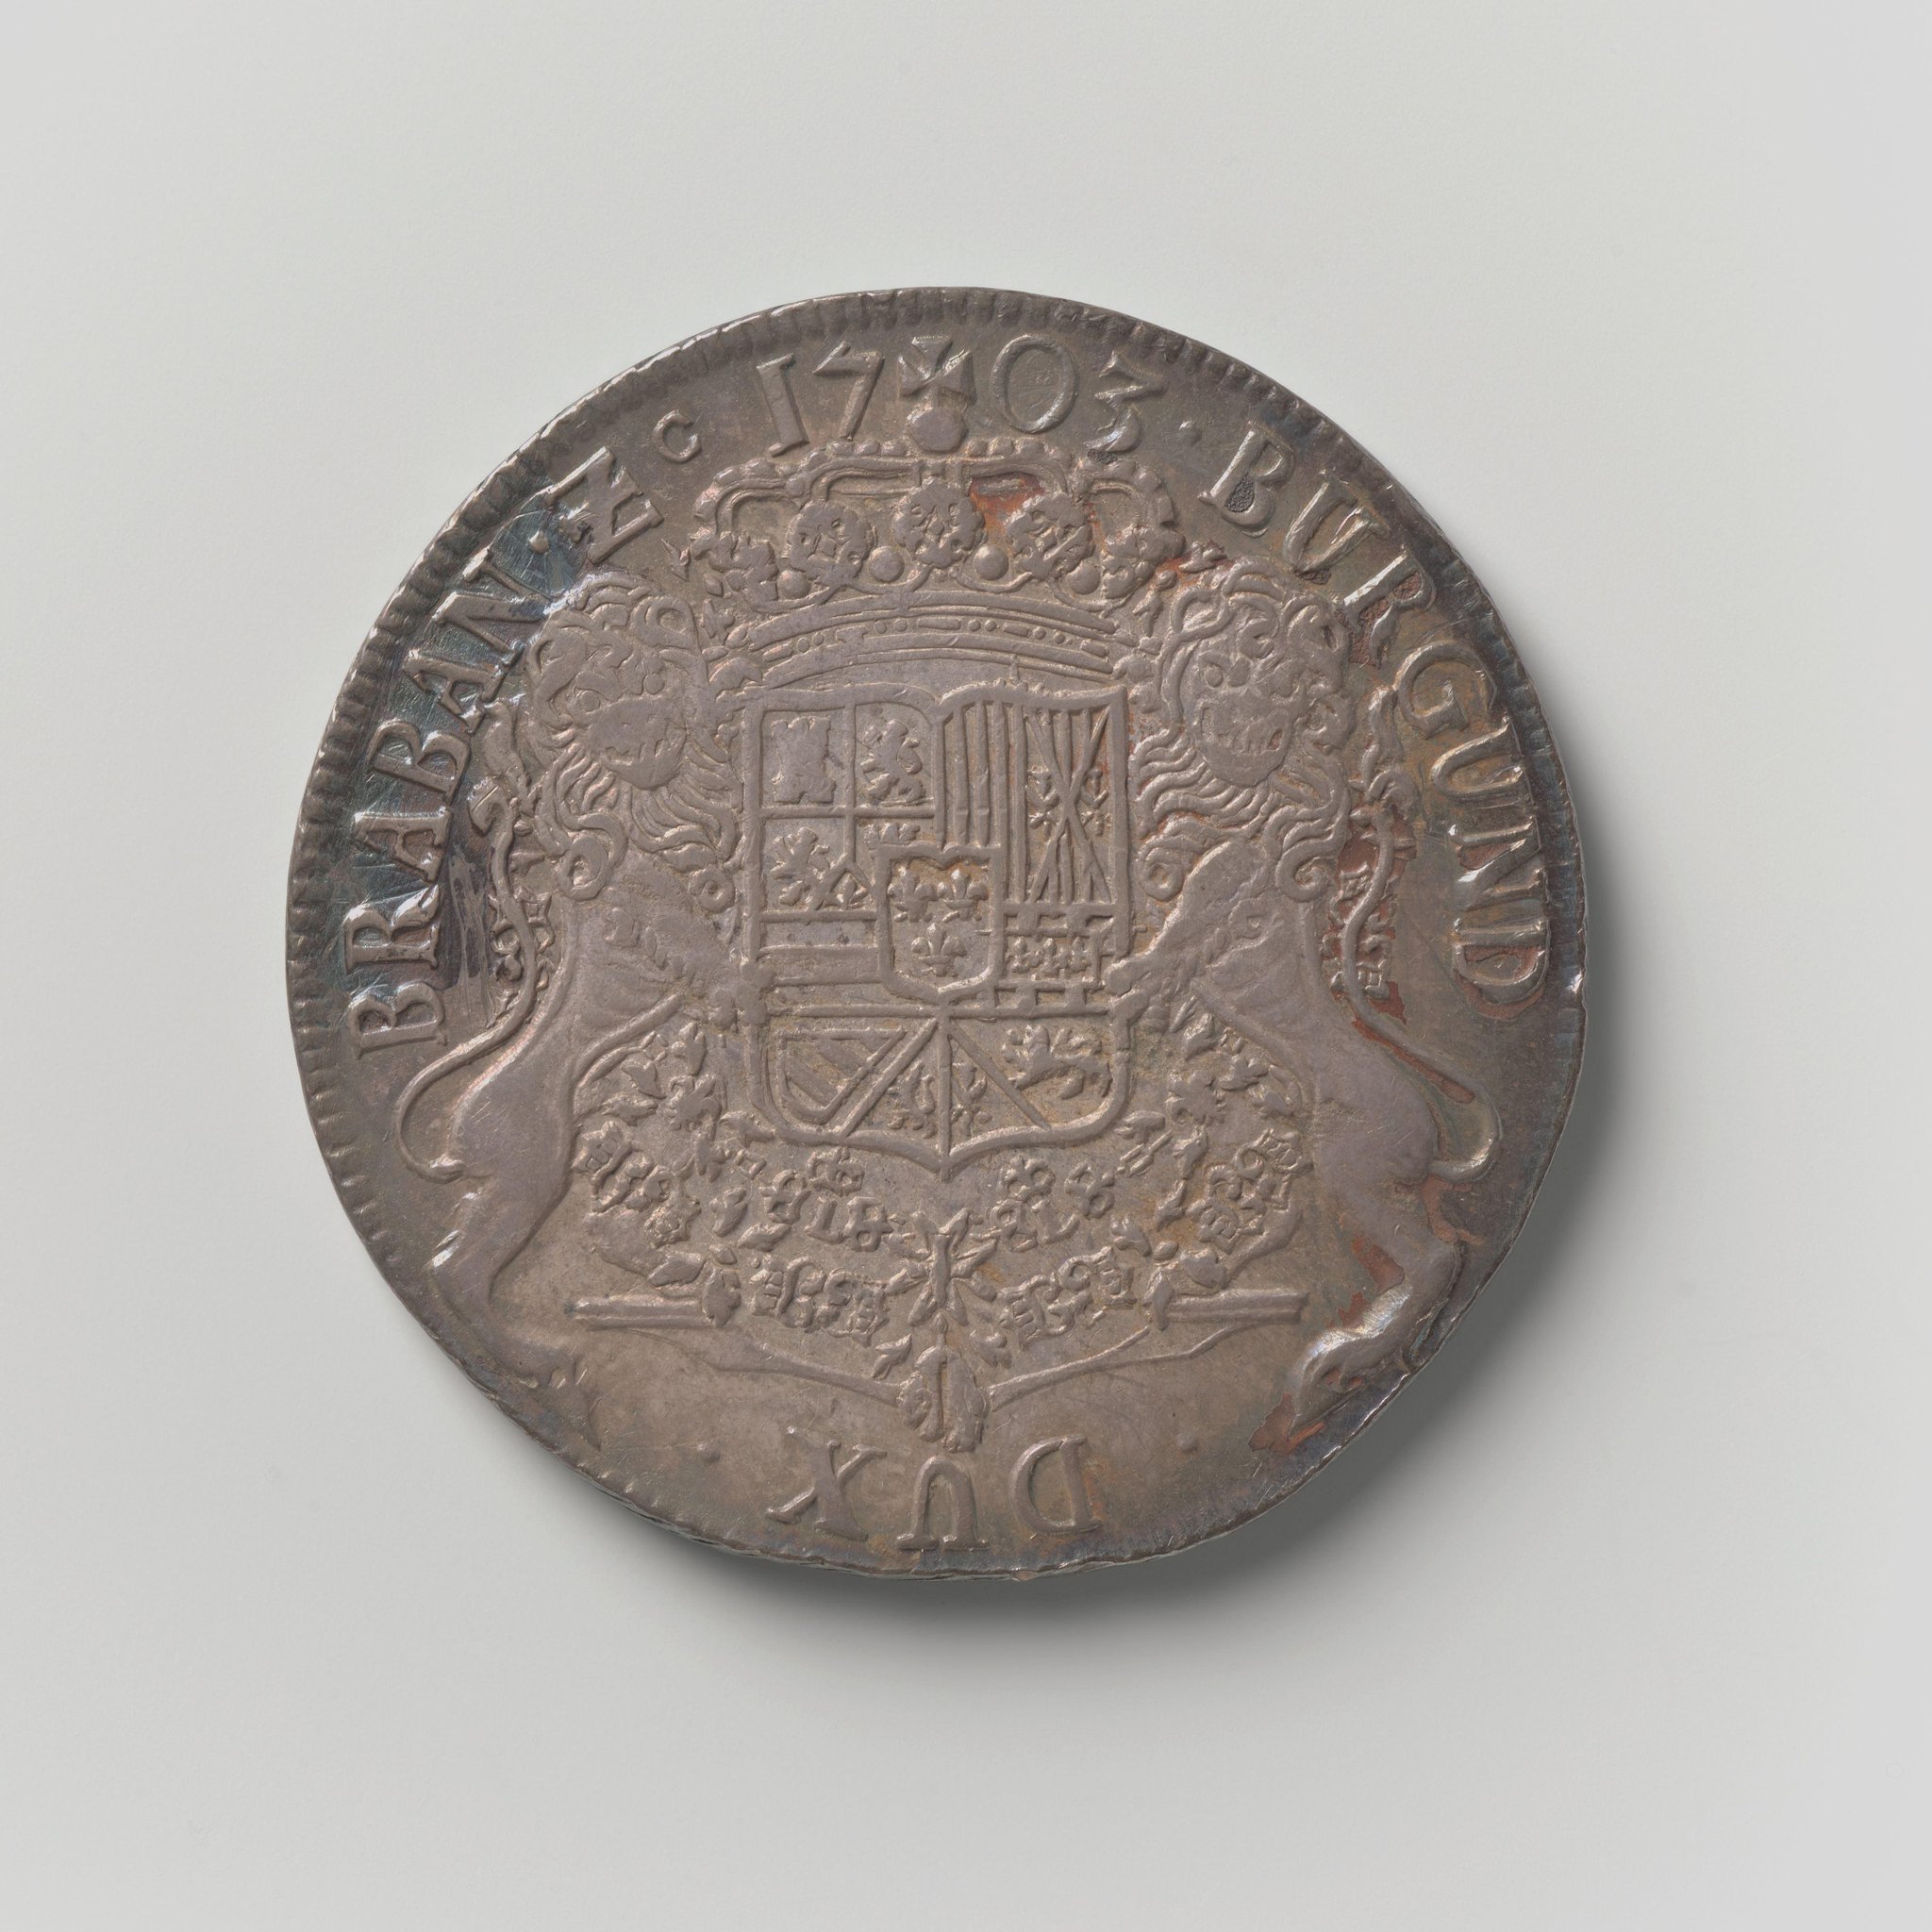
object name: coin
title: Dukaton uit Brabant van Philips V, 1703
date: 1703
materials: silver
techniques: striking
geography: antwerp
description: Zilveren munt. Voorzijde: portret van Philips V met laag reliëf naar rechts. Hand onder portret. Keerzijde: door twee leeuwen gehouden door keten van de heilige geest en keten van het gulden vlies omhangen gekroond samengesteld wapenschild. Jaartal rondom kroon. Kabelrand.